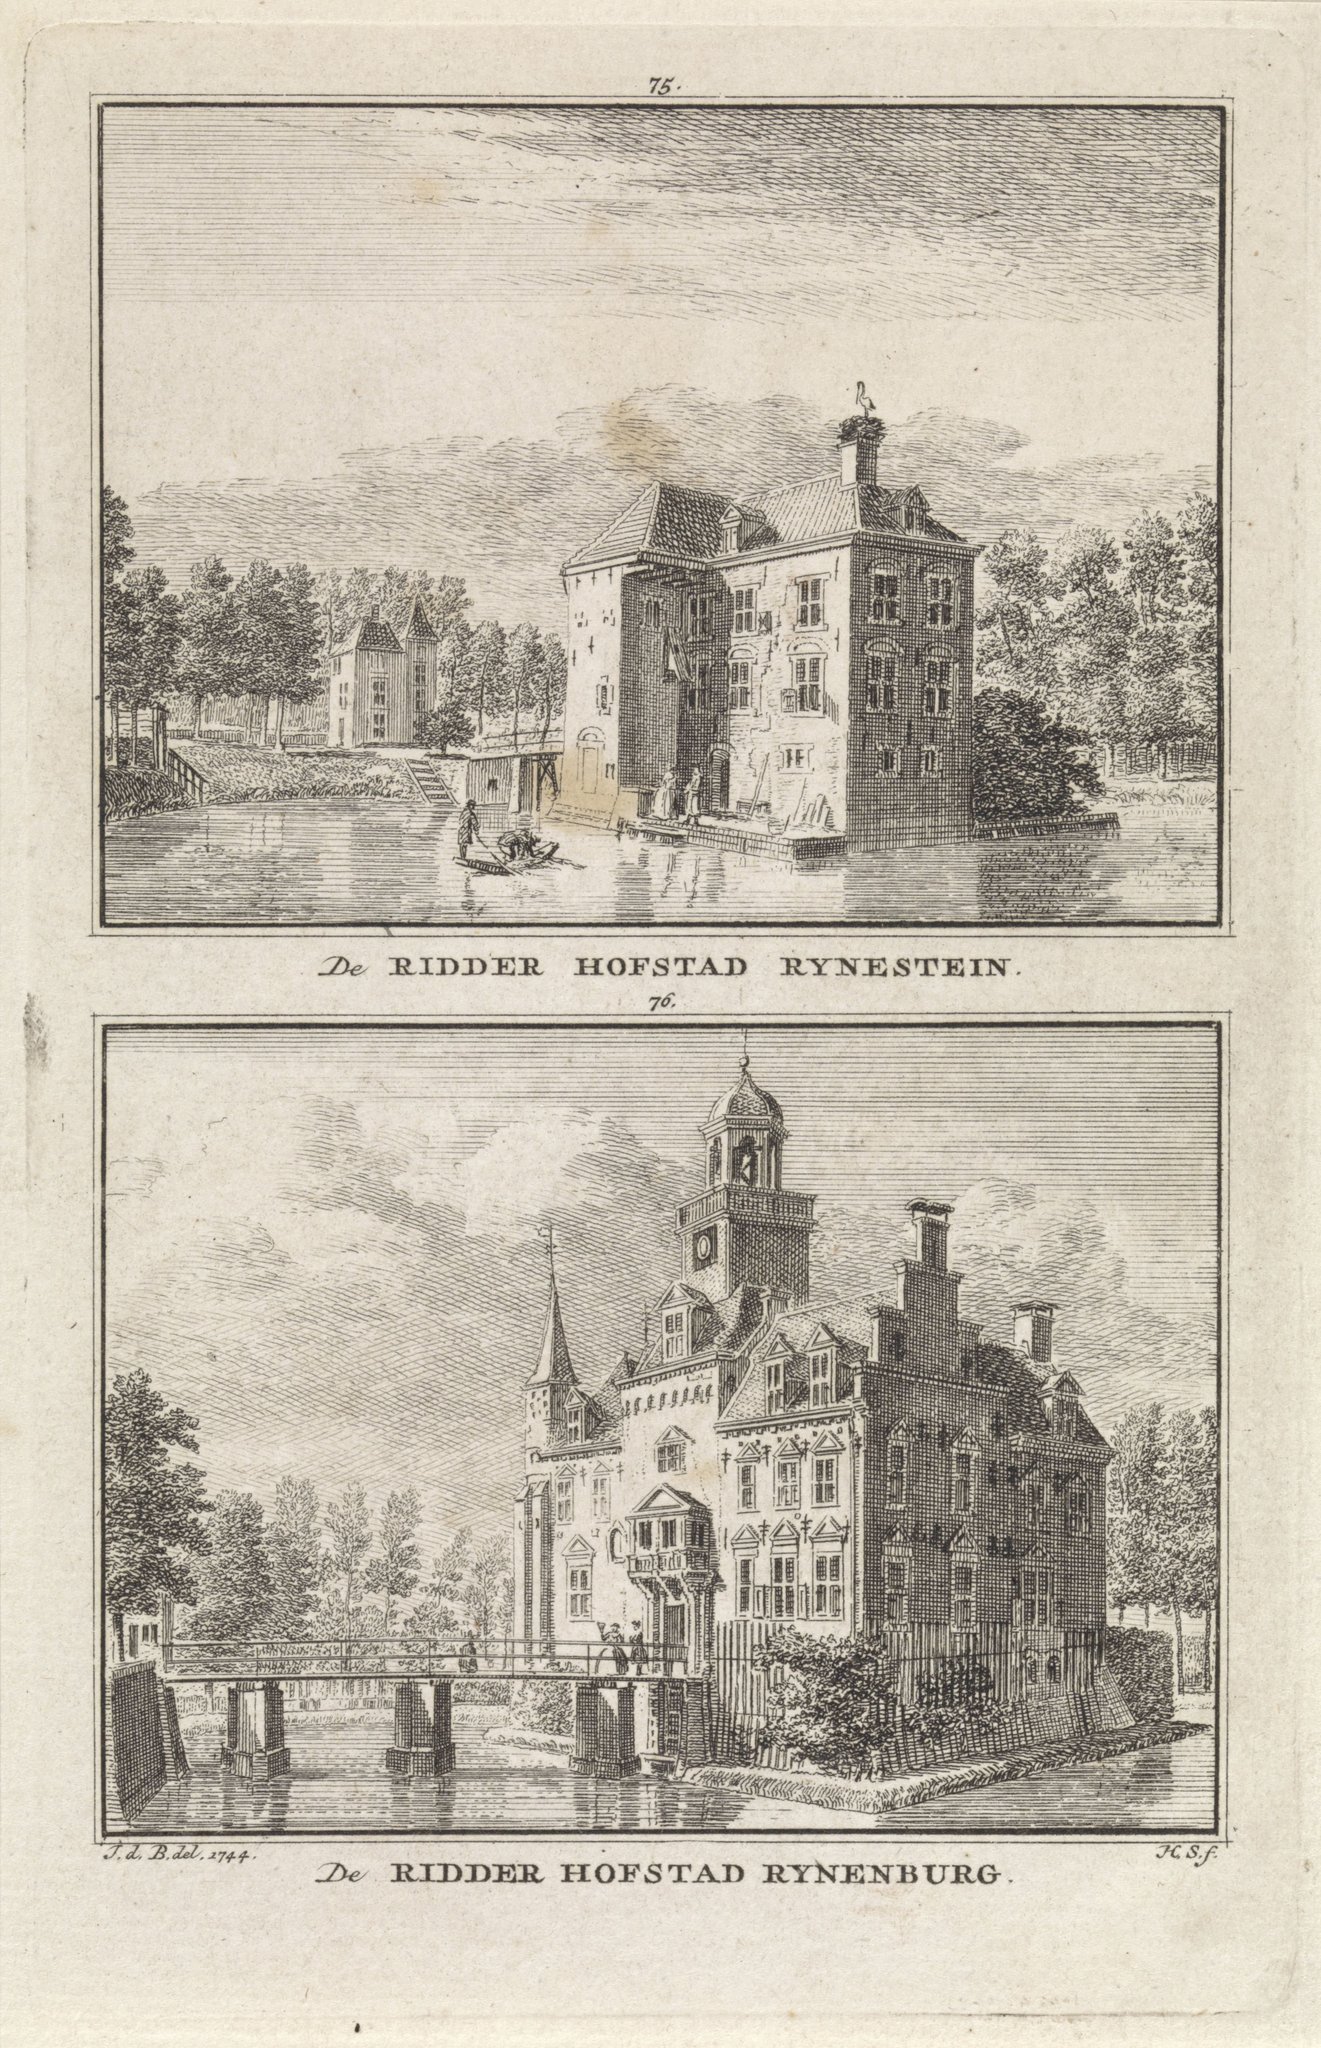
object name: book illustration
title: Gezicht op kasteel Rijnestein en kasteel Rijnenburg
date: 1773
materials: paper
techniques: etching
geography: haarlem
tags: castle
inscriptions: collector's mark: Lugt 2228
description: Prent gebruikt in: Het verheerlykt Nederland of kabinet van hedendaagsche gezigten van steden, dorpen, sloten ... en andere voornaame stad- en landgebouwen, in en omtrent alle de byzondere Vereenigde Nederlandsche Provinciën : gedurende de laatste jaaren door vermaarden kunsttekenaren na het leven getekent en ... in 't koper gebragt ... dienende tot opheldering der beschryvinge van den Tegenwoordigen Staat der Vereenigde Nederlanden. Deel VII, 1773. Amsterdam: Isaac Tirion, 1745-1774.